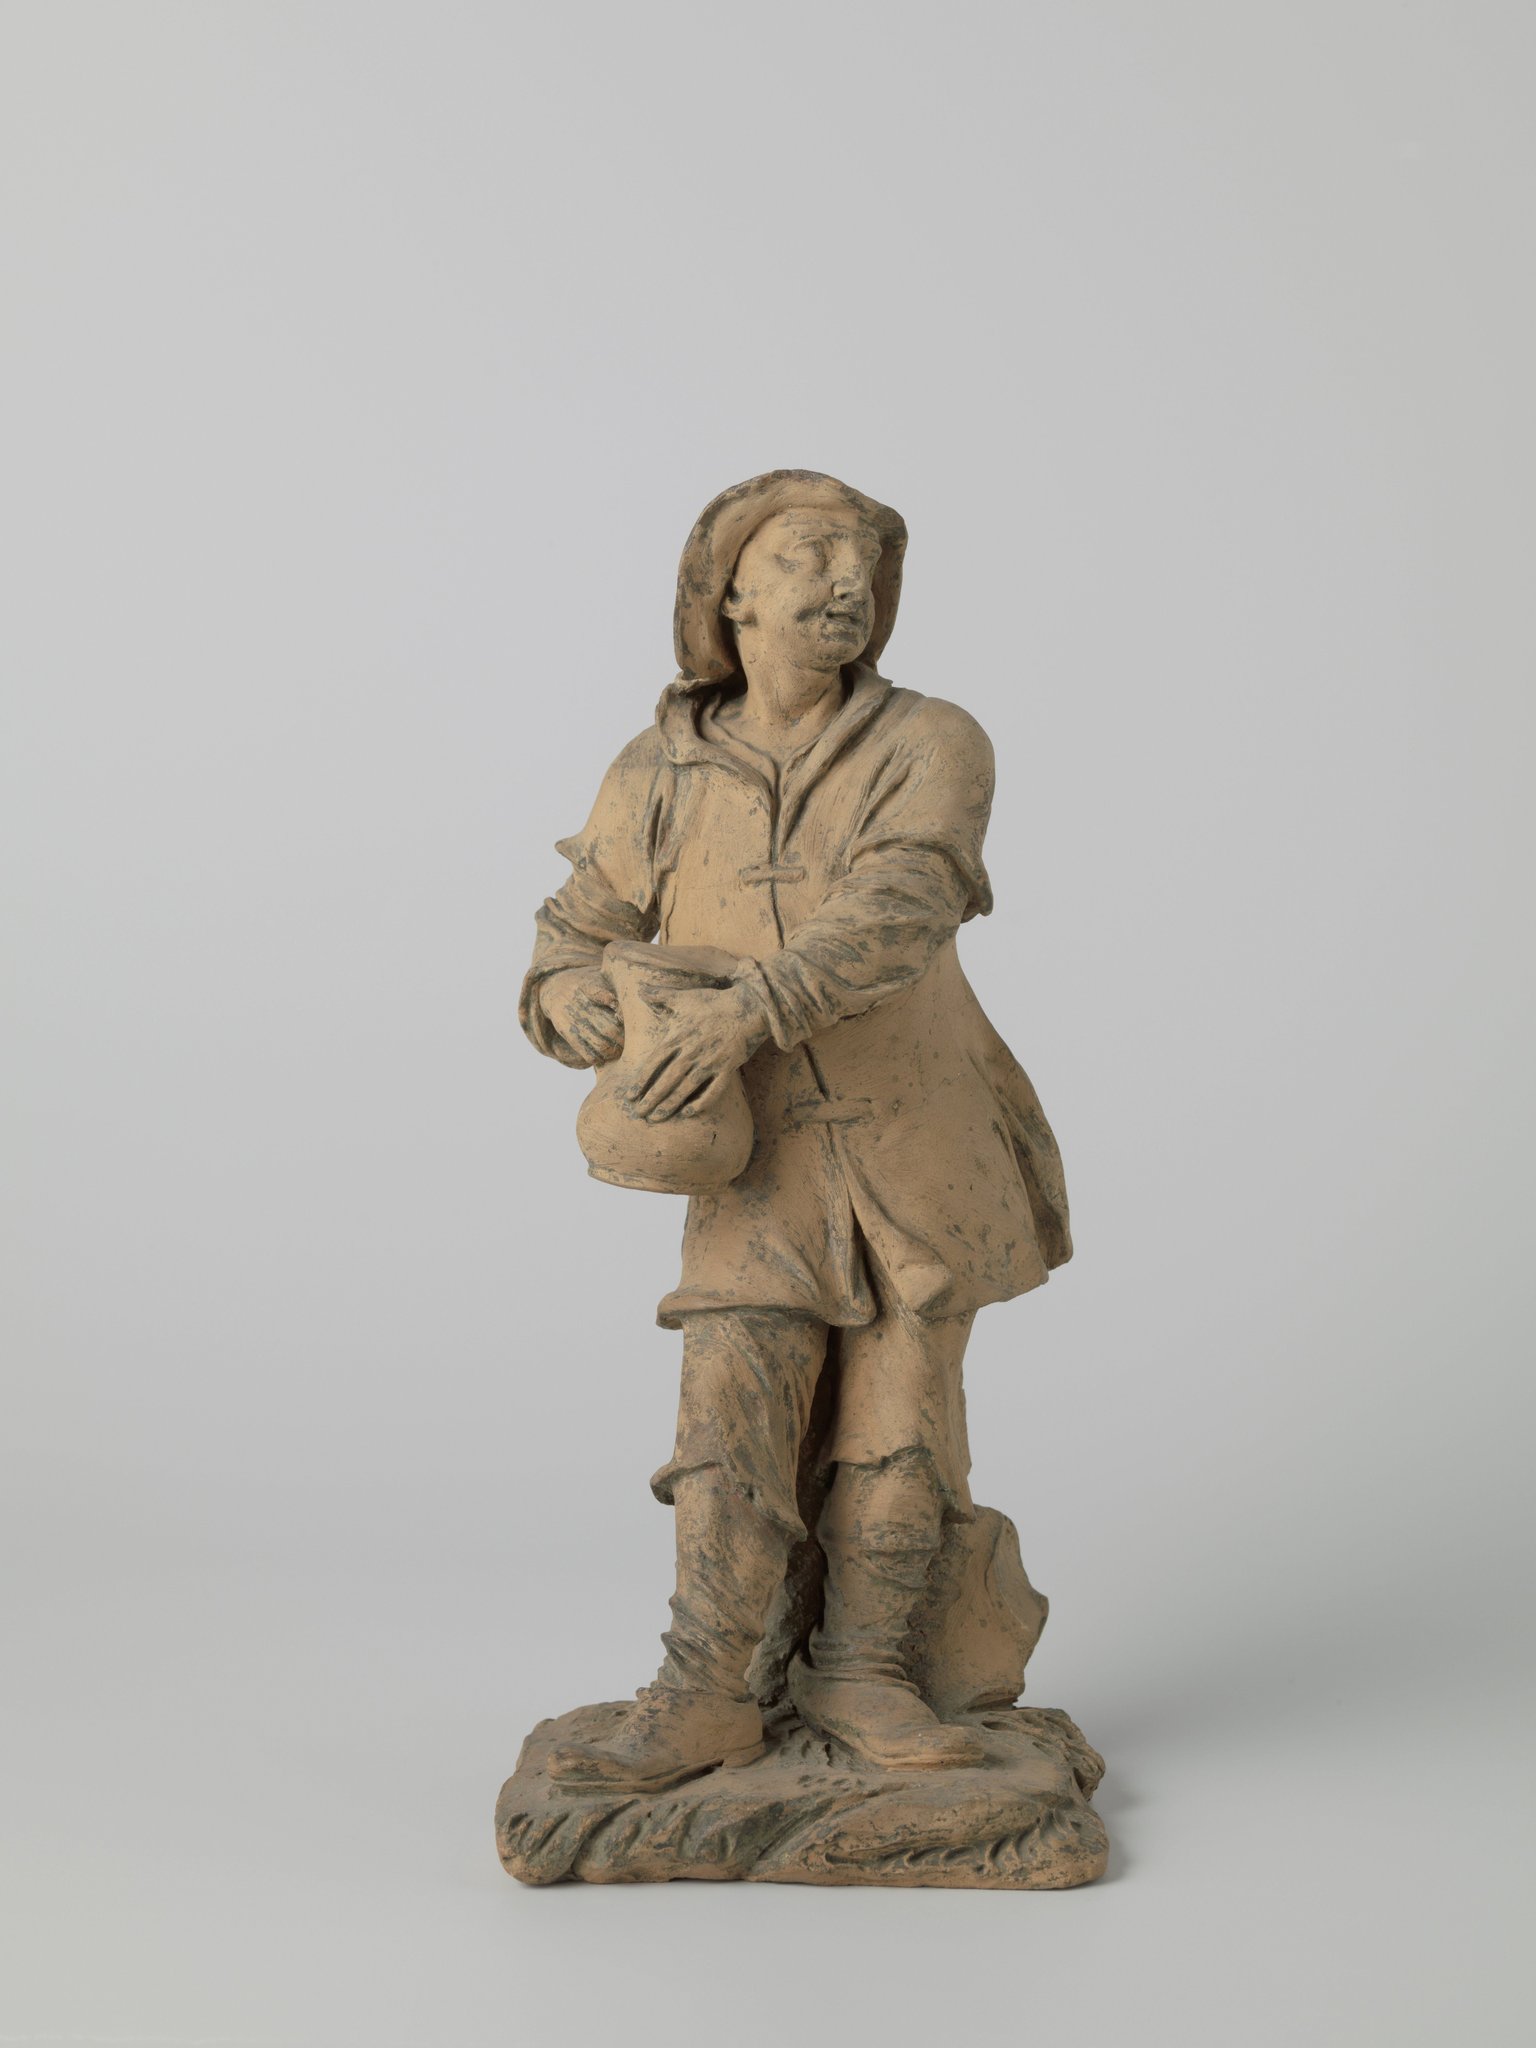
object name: sculpture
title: Landloper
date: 1700-1749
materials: terracotta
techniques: modeling, painting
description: Man op een rechthoekig grondje met het rechterbeen naar voren en het linker tegen een rotsachtige verhoging. Met beide handen houdt hij tegen zijn rechterzijde een tinnen flapkan, terwijl zijn hoofd naar rechts is gewend. Hij draagt een slappe hoed, een jak met halve mouwen en een hemd. Voorts een gerafelde broek, die even over de knieën reikt en kousen, die gedraaid om zijn benen zitten. De voeten steken in grote lage schoenen.